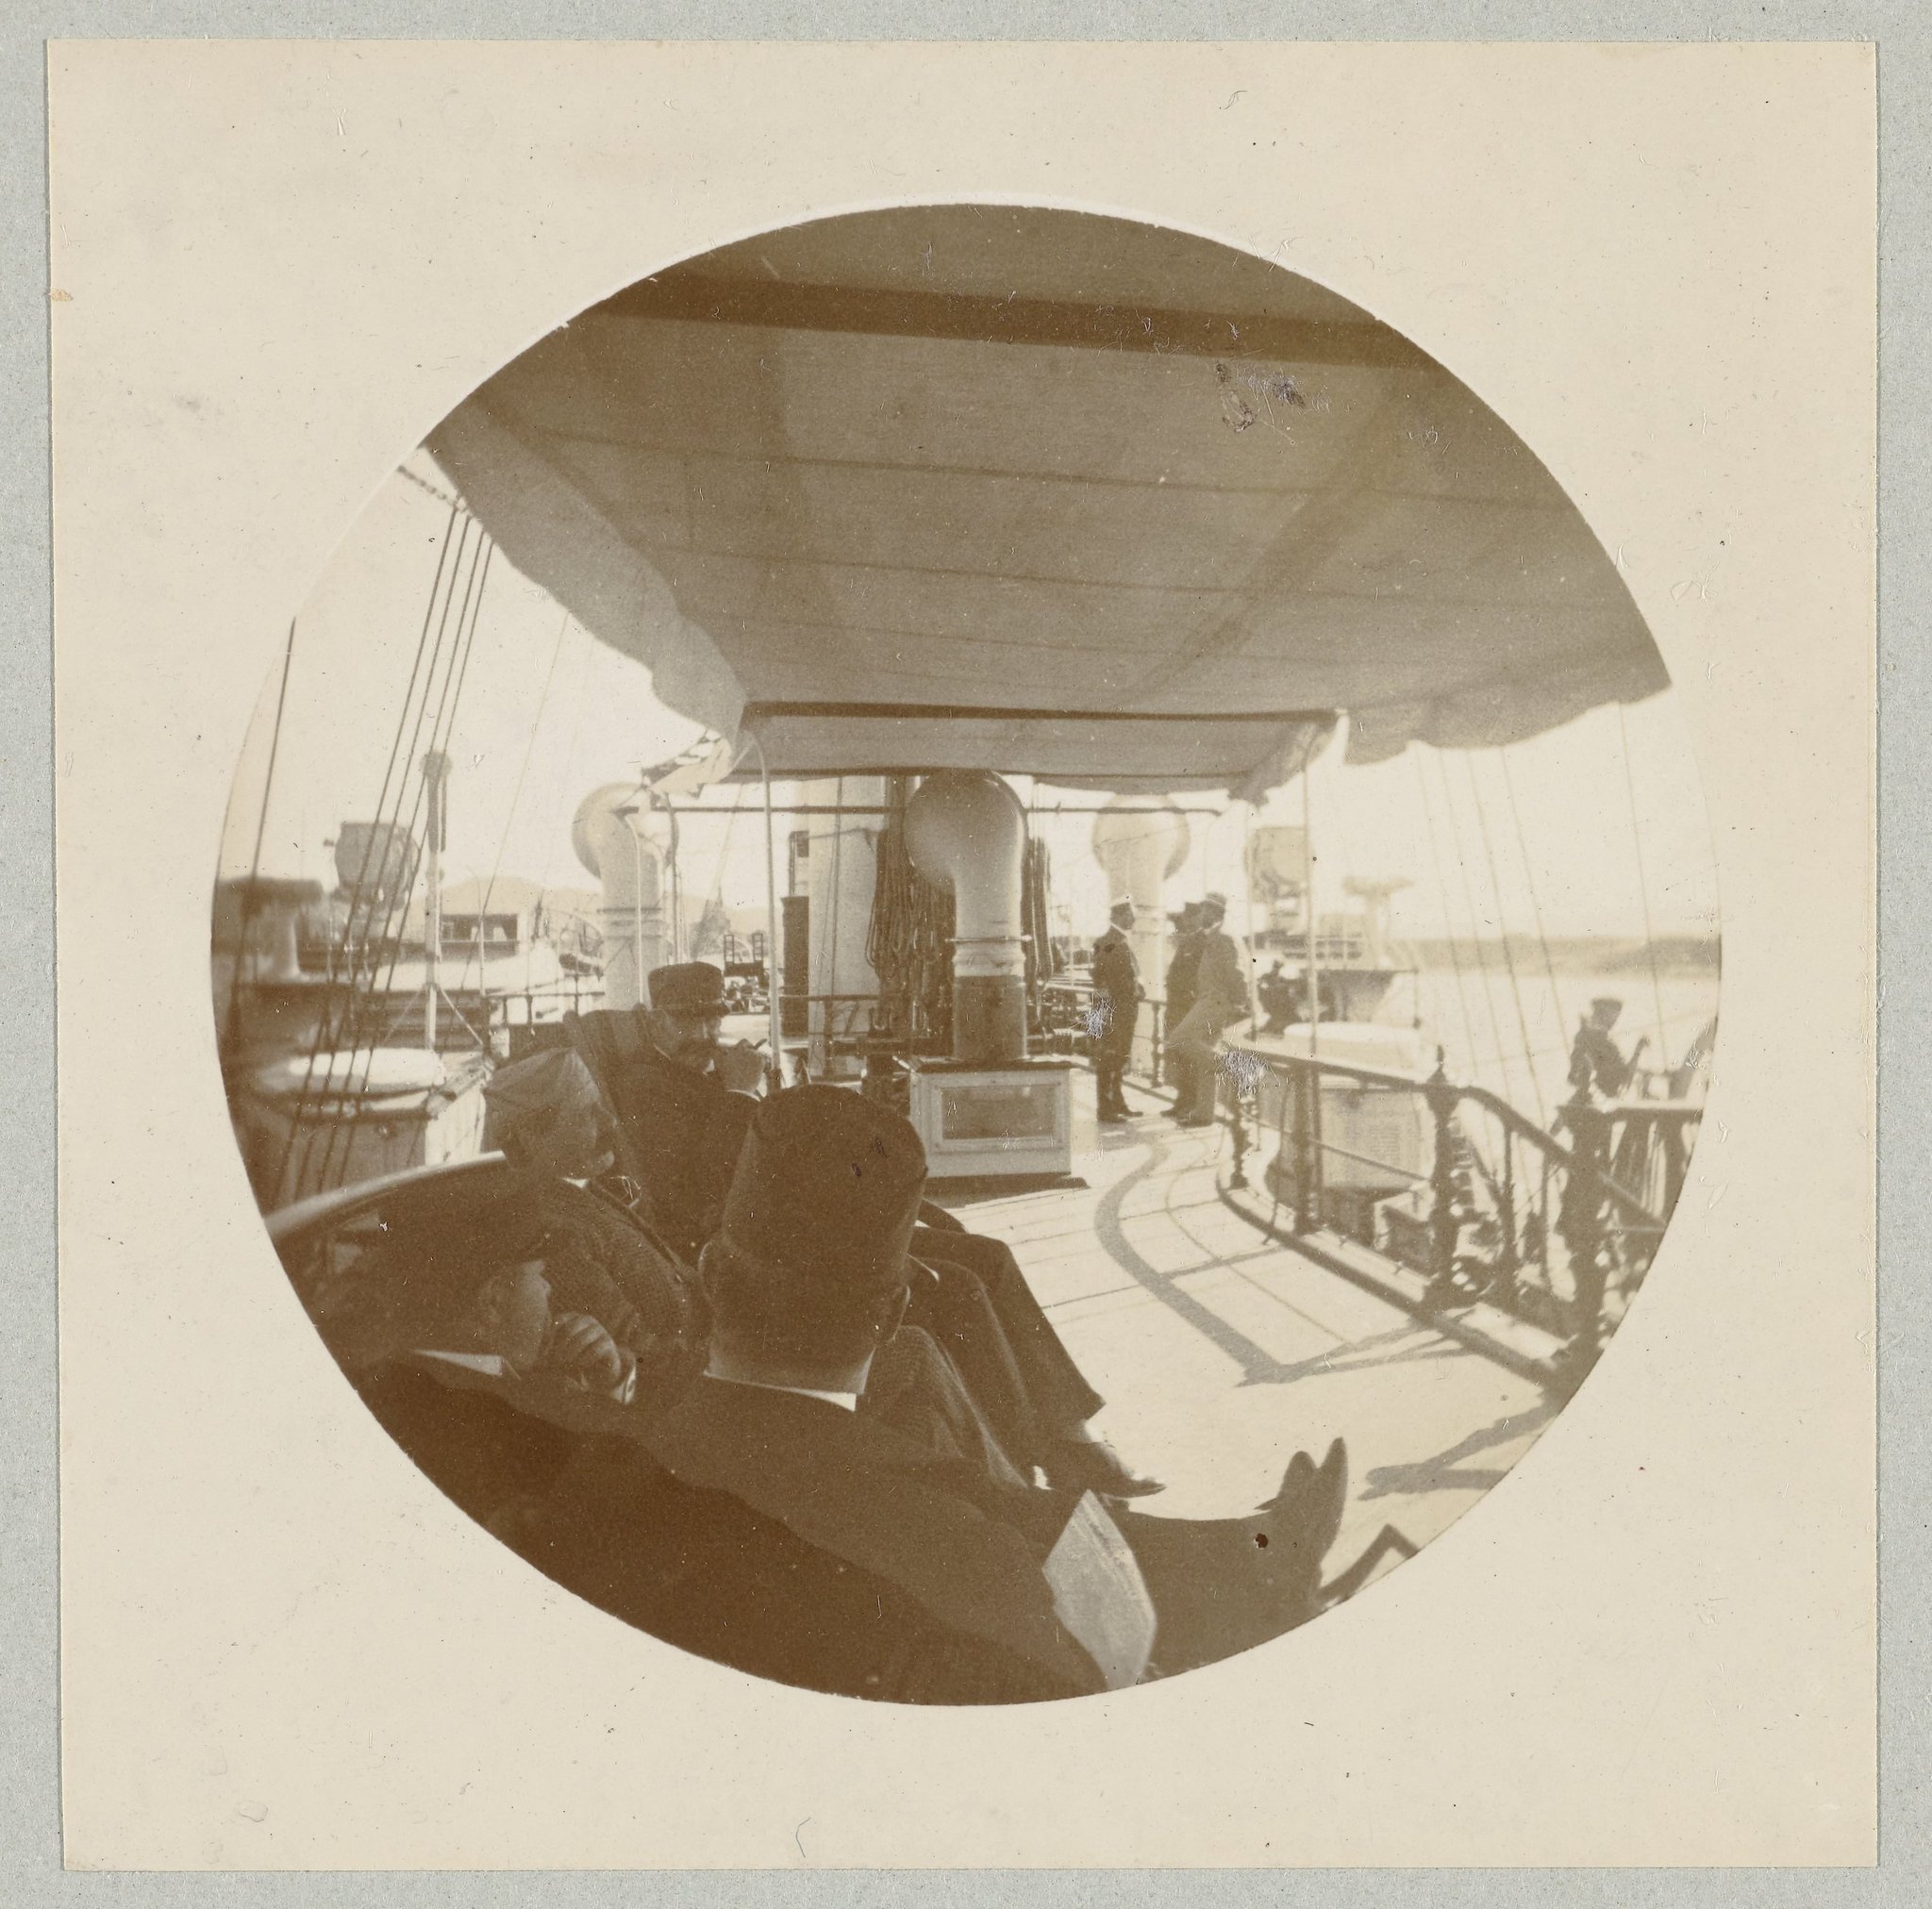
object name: photograph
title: Reisgenoten van Keizer Wilhelm II aan boord van de Hohenzollern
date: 1807-1889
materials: cardboard, paper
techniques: gelatin silver print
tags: wilhelm ii (keizer van duitsland), norway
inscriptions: number: ‘1a’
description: De foto is rond maar is afgedrukt op vierkant papier